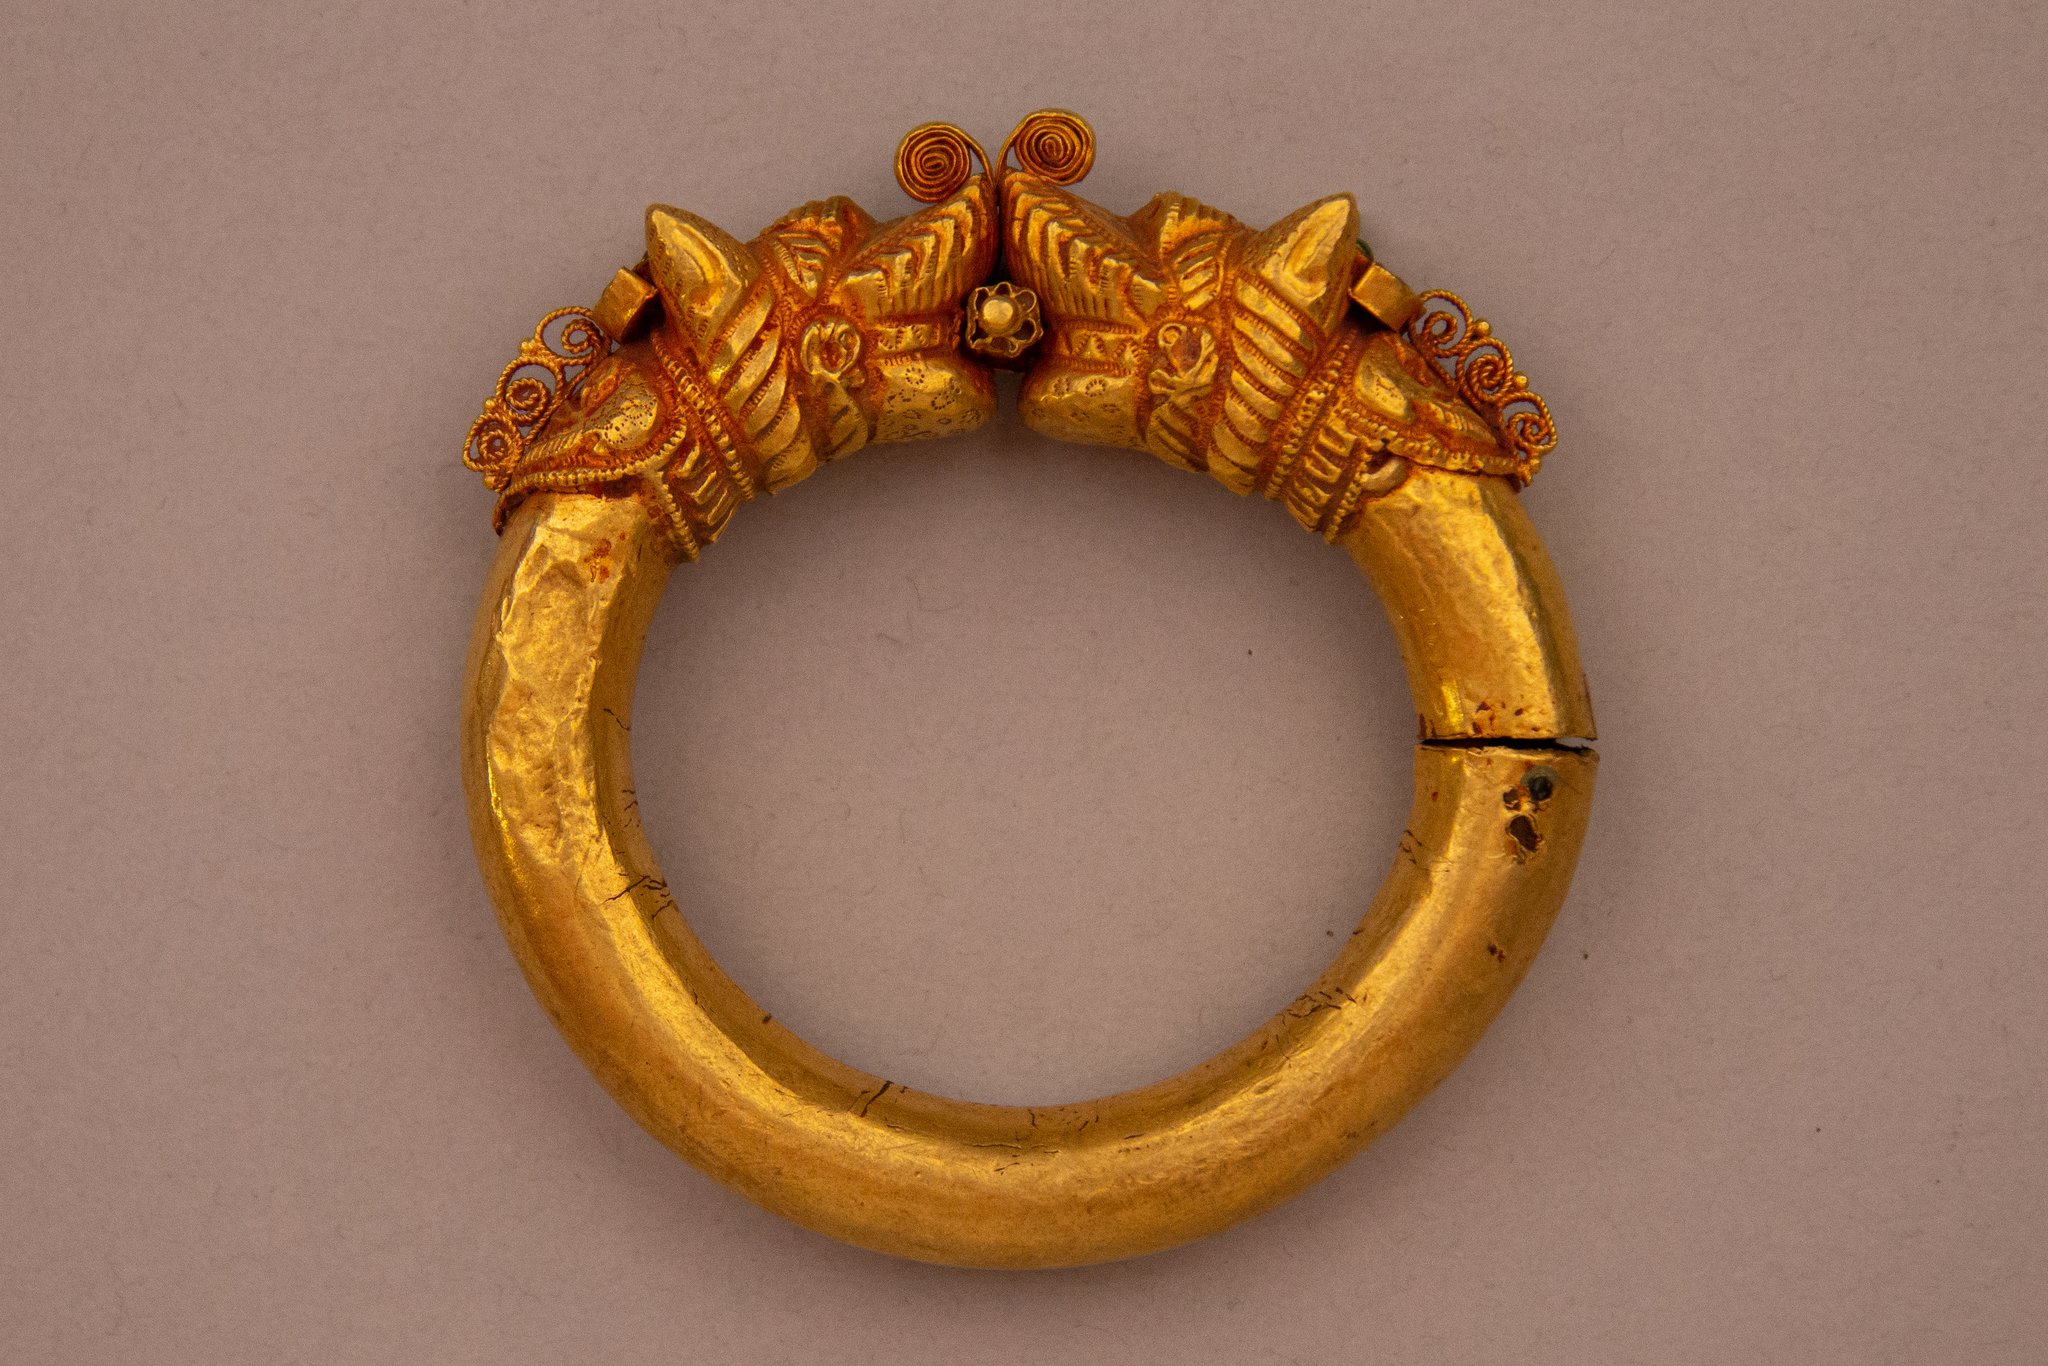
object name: bracelet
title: Bracelet (Kada), One of a Pair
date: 1801-1900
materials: gemstone, gold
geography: india